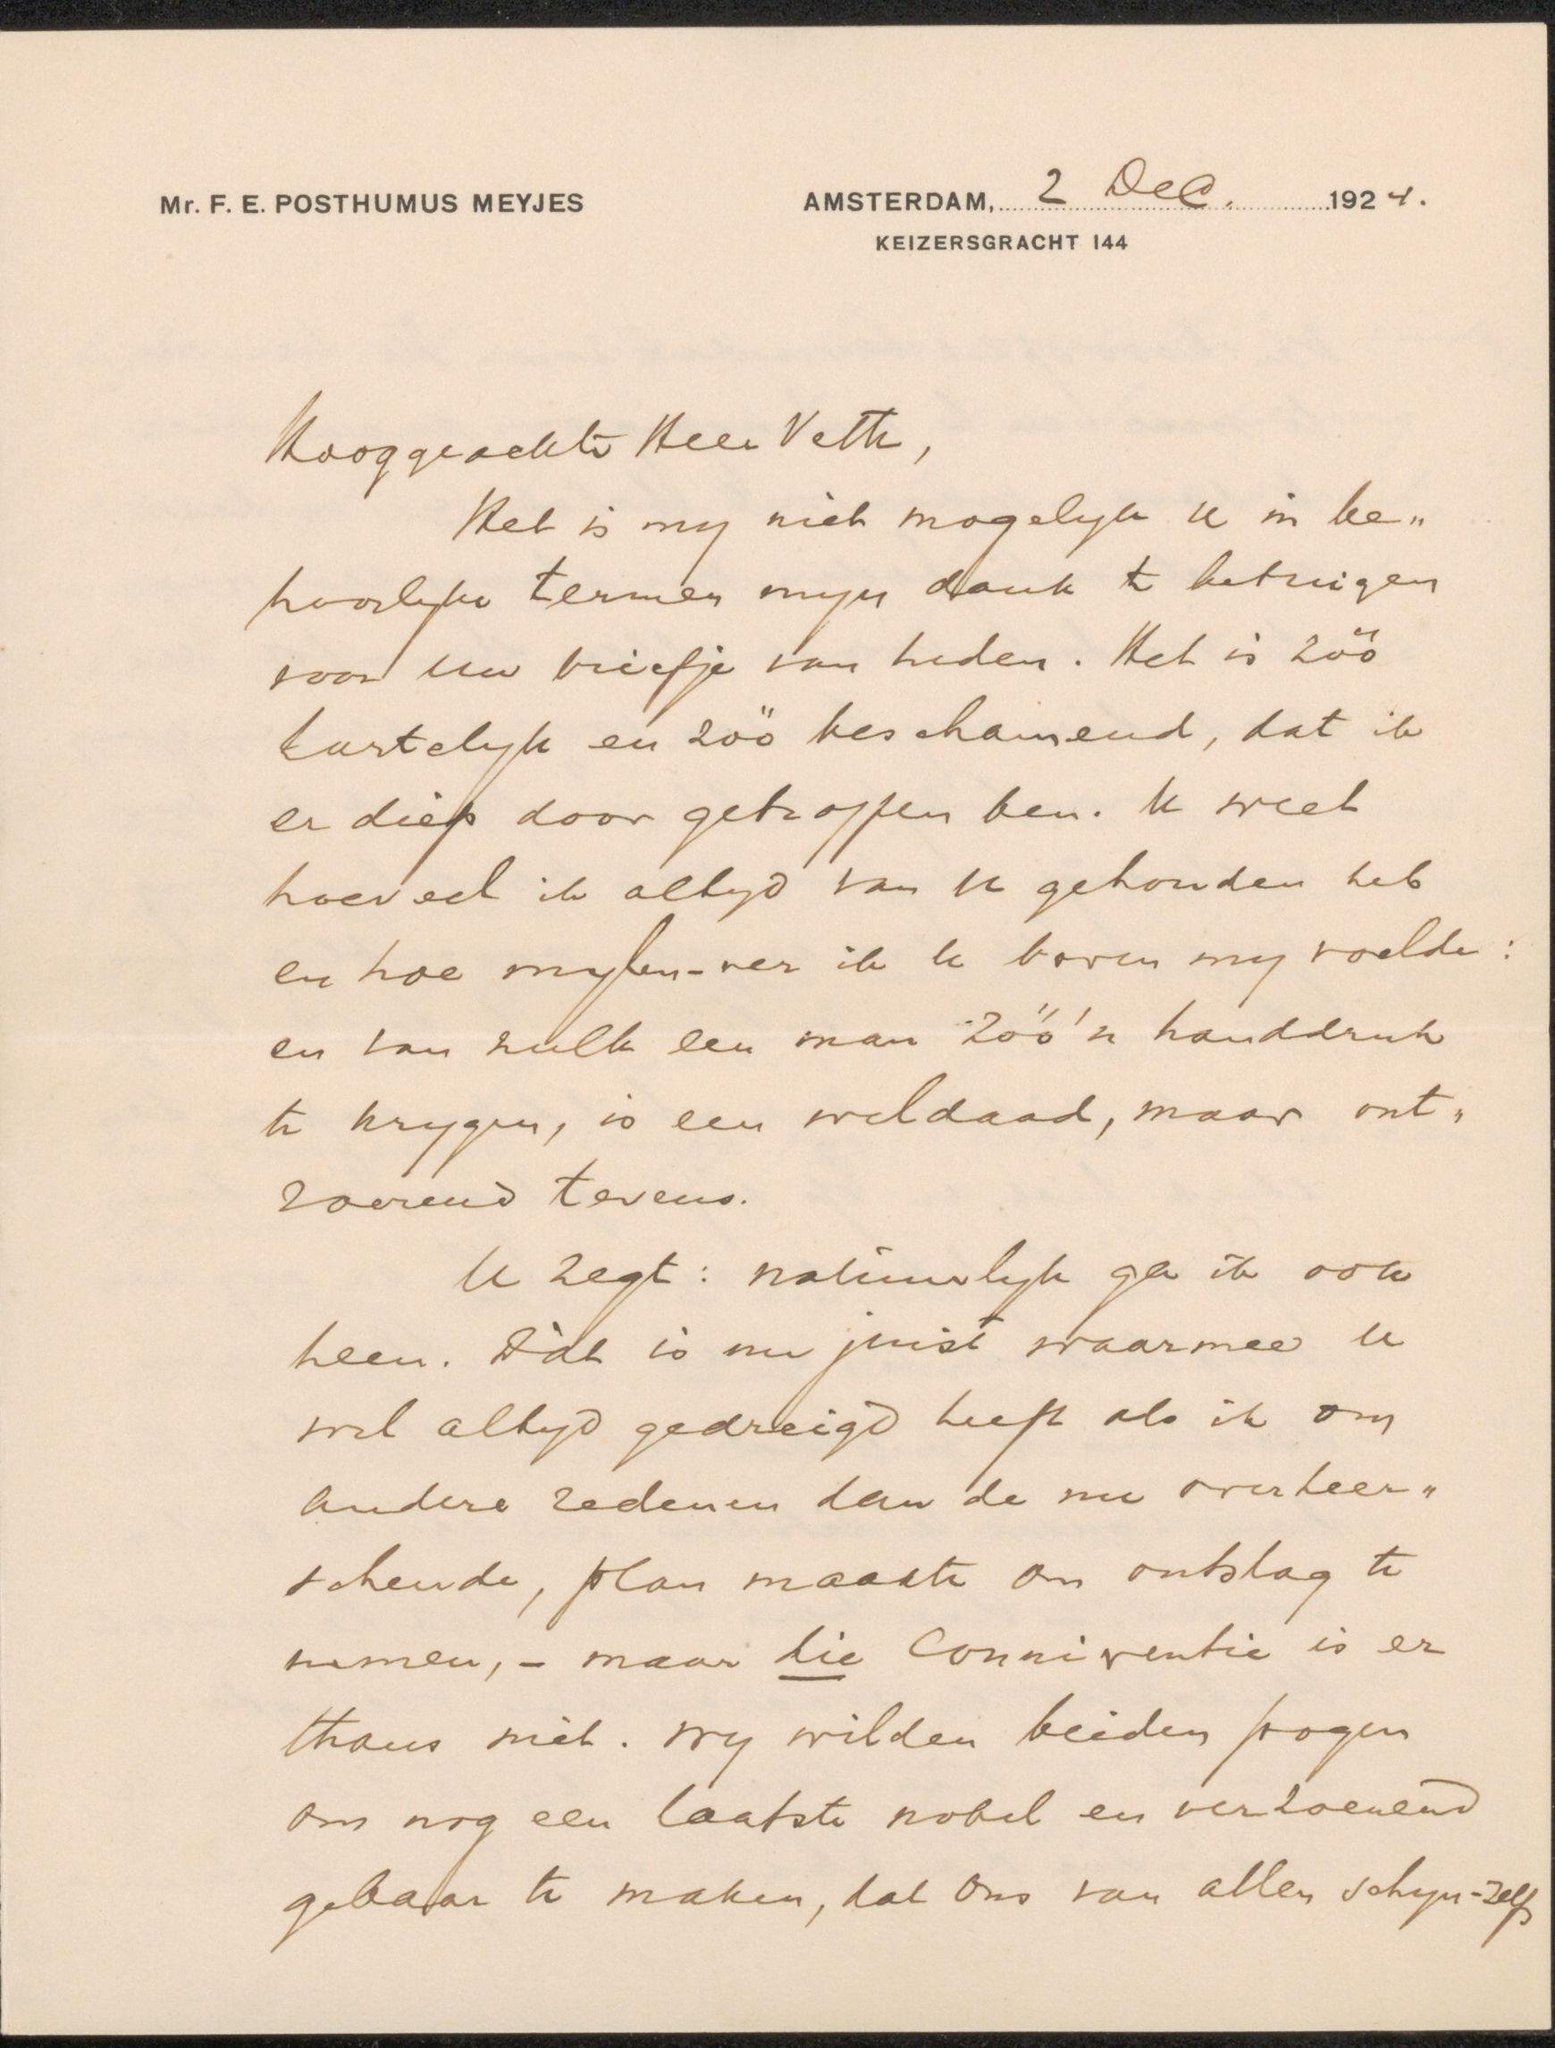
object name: letter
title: Brief aan Jan Veth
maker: f.e. posthumus meyjes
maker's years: 1865-1926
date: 1924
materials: ink, paper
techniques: pen, printing, writing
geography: amsterdam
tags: dordrecht, amsterdam, painter, print maker, draughtsman, designer, jan veth, passions, emotions, affections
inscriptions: name: ‘Mr. F.E. POSTHUMUS MEYJES’, collector's mark: ‘RPK’